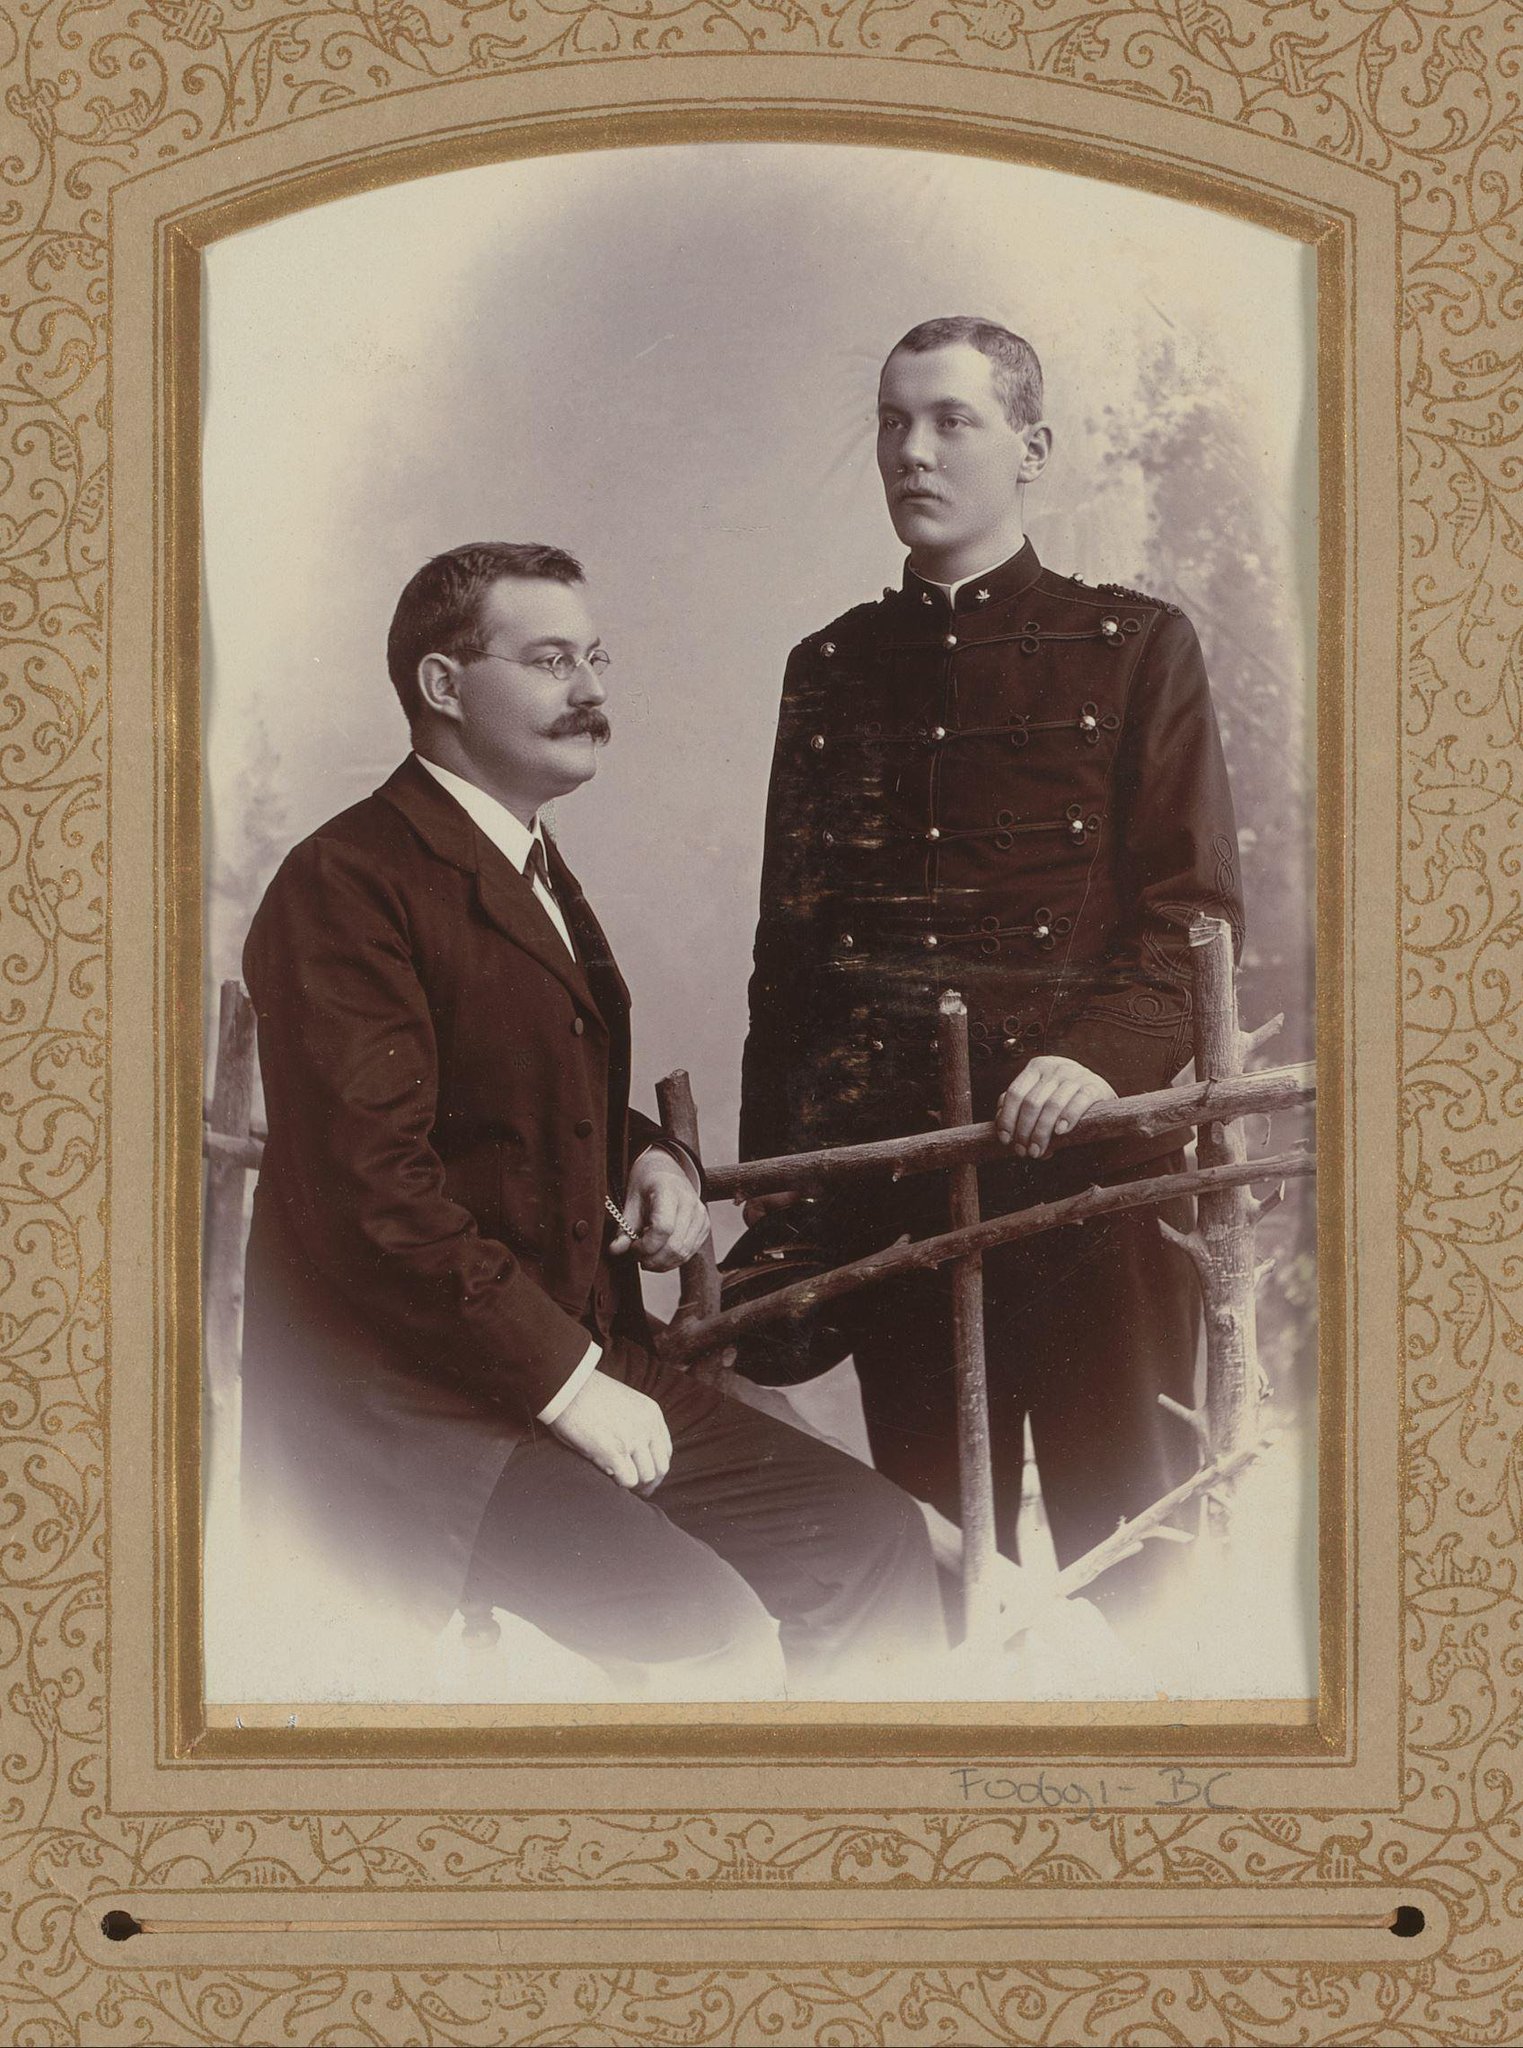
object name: album leaf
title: Portret van twee mannen bij een hek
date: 1880-1915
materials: cardboard, photographic support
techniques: collodion silver print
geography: batavia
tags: historical persons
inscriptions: inscription: ‘Photografie/ Charls 7 van Es & Co./ Batavia’, annotation: ‘[A]lama’